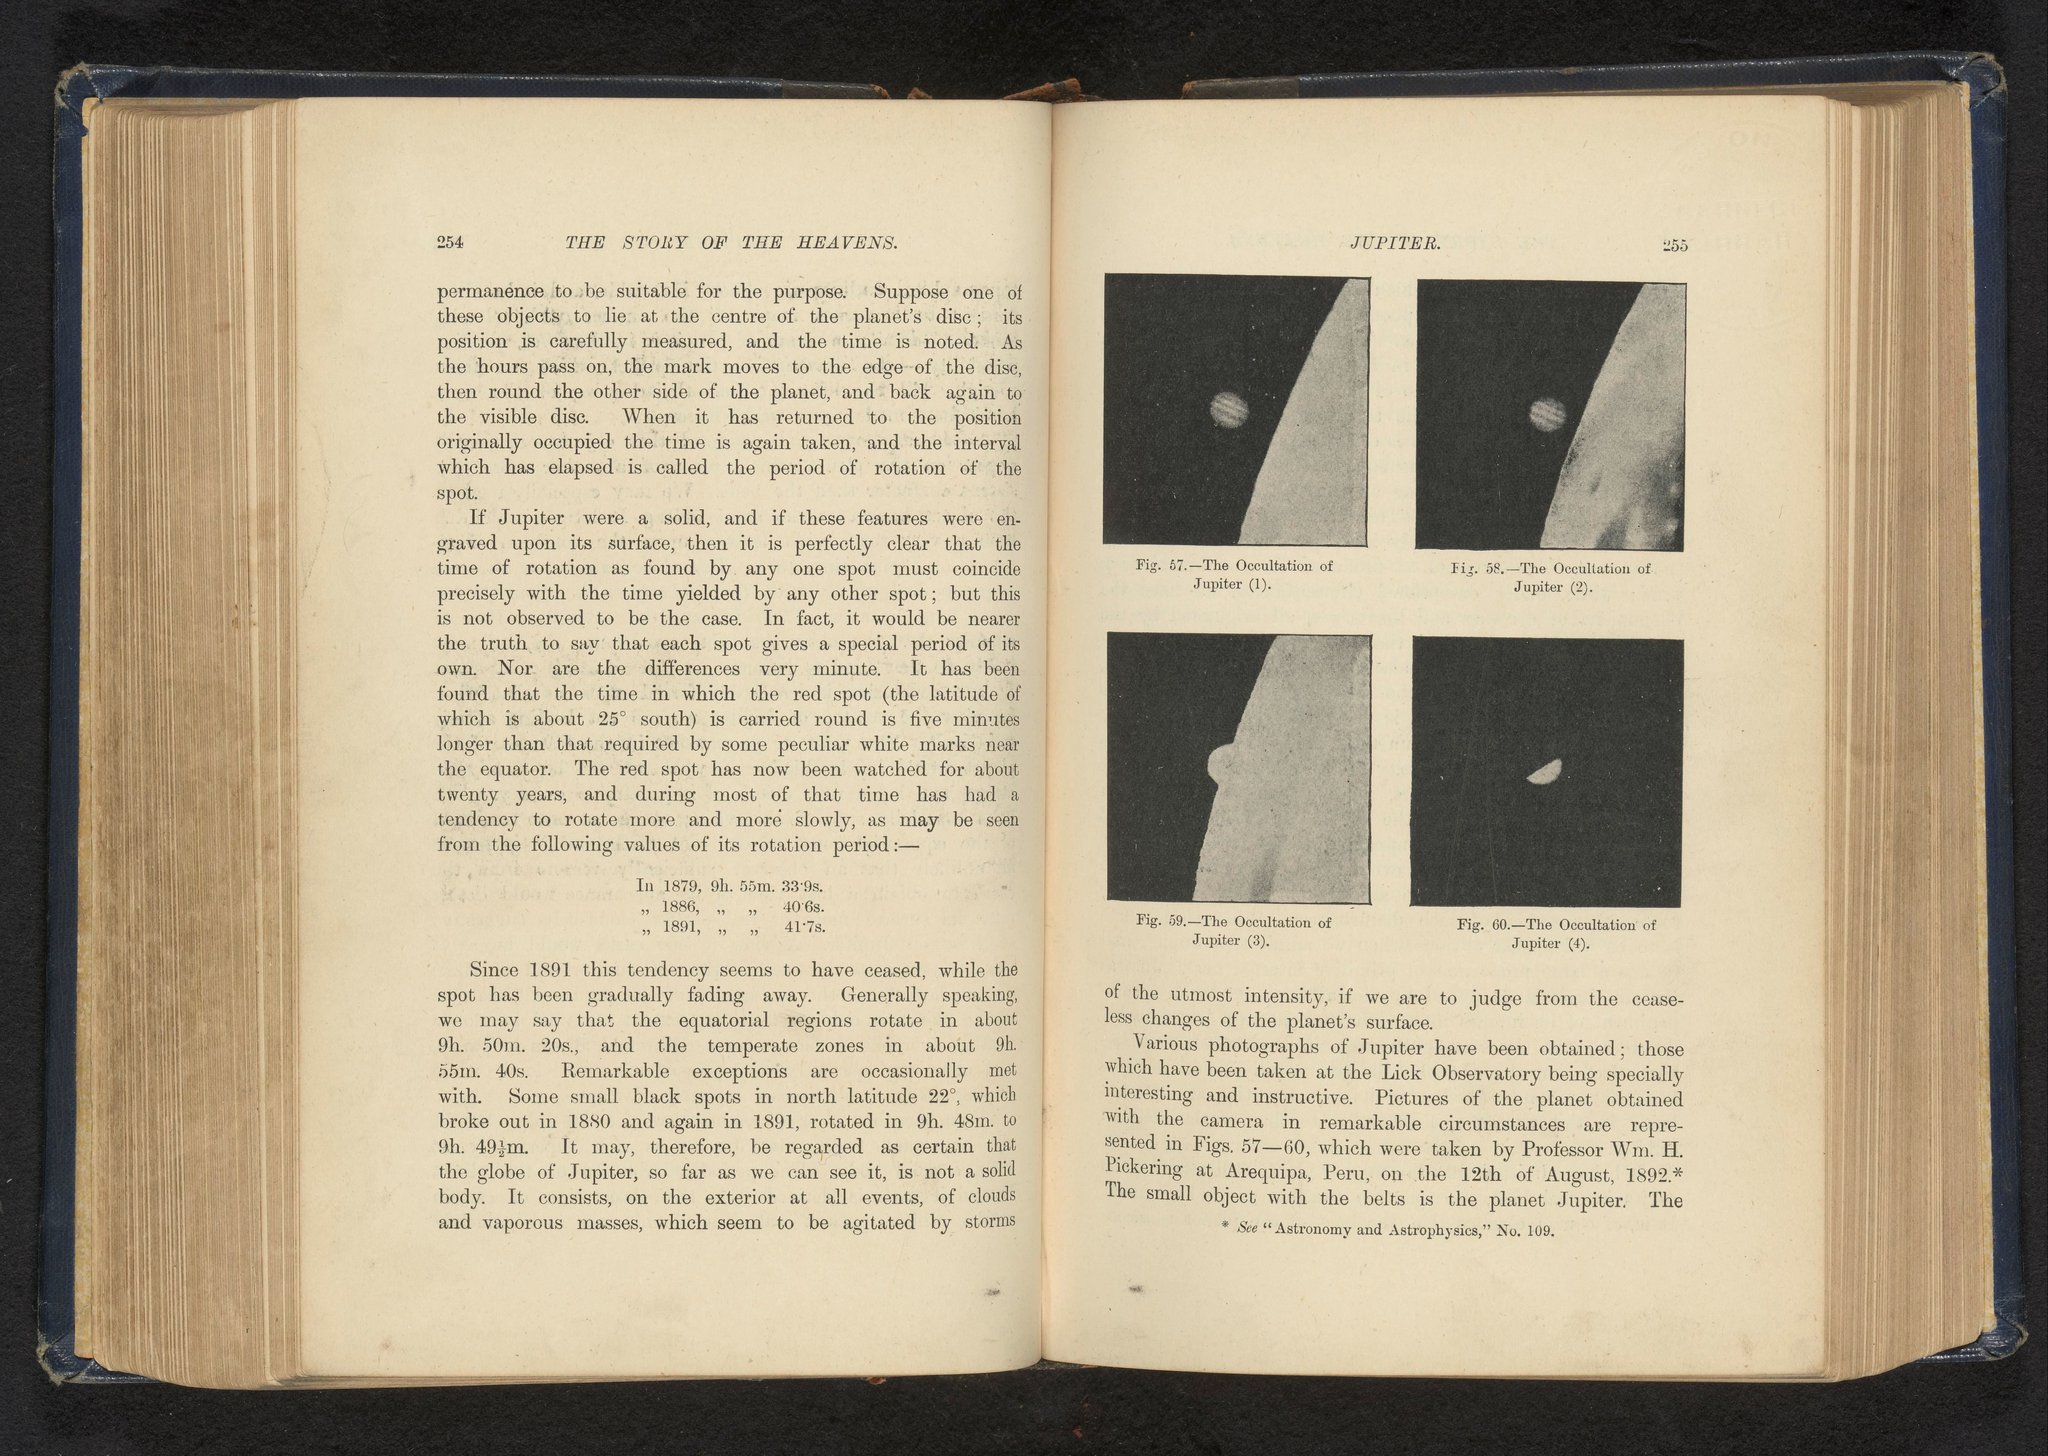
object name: photomechanical print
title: Vier fasen van de verduistering van Jupiter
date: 1892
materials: paper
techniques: autotype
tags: jupiter (planet)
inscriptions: inscription: ‘The Occultation of Jupiter (1). (...) (4).’, number: ‘Fig. 57. (...) 60.’